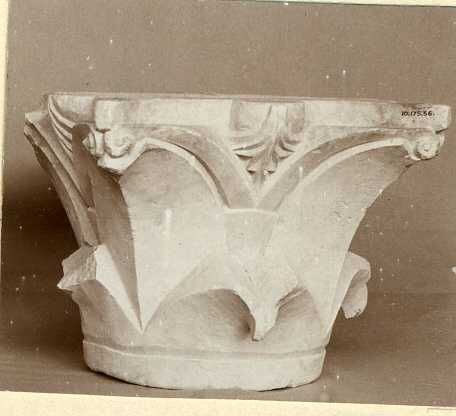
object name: capital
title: Capital with Acanthus and Palm Leaves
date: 501-700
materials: limestone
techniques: carving, relief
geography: egypt